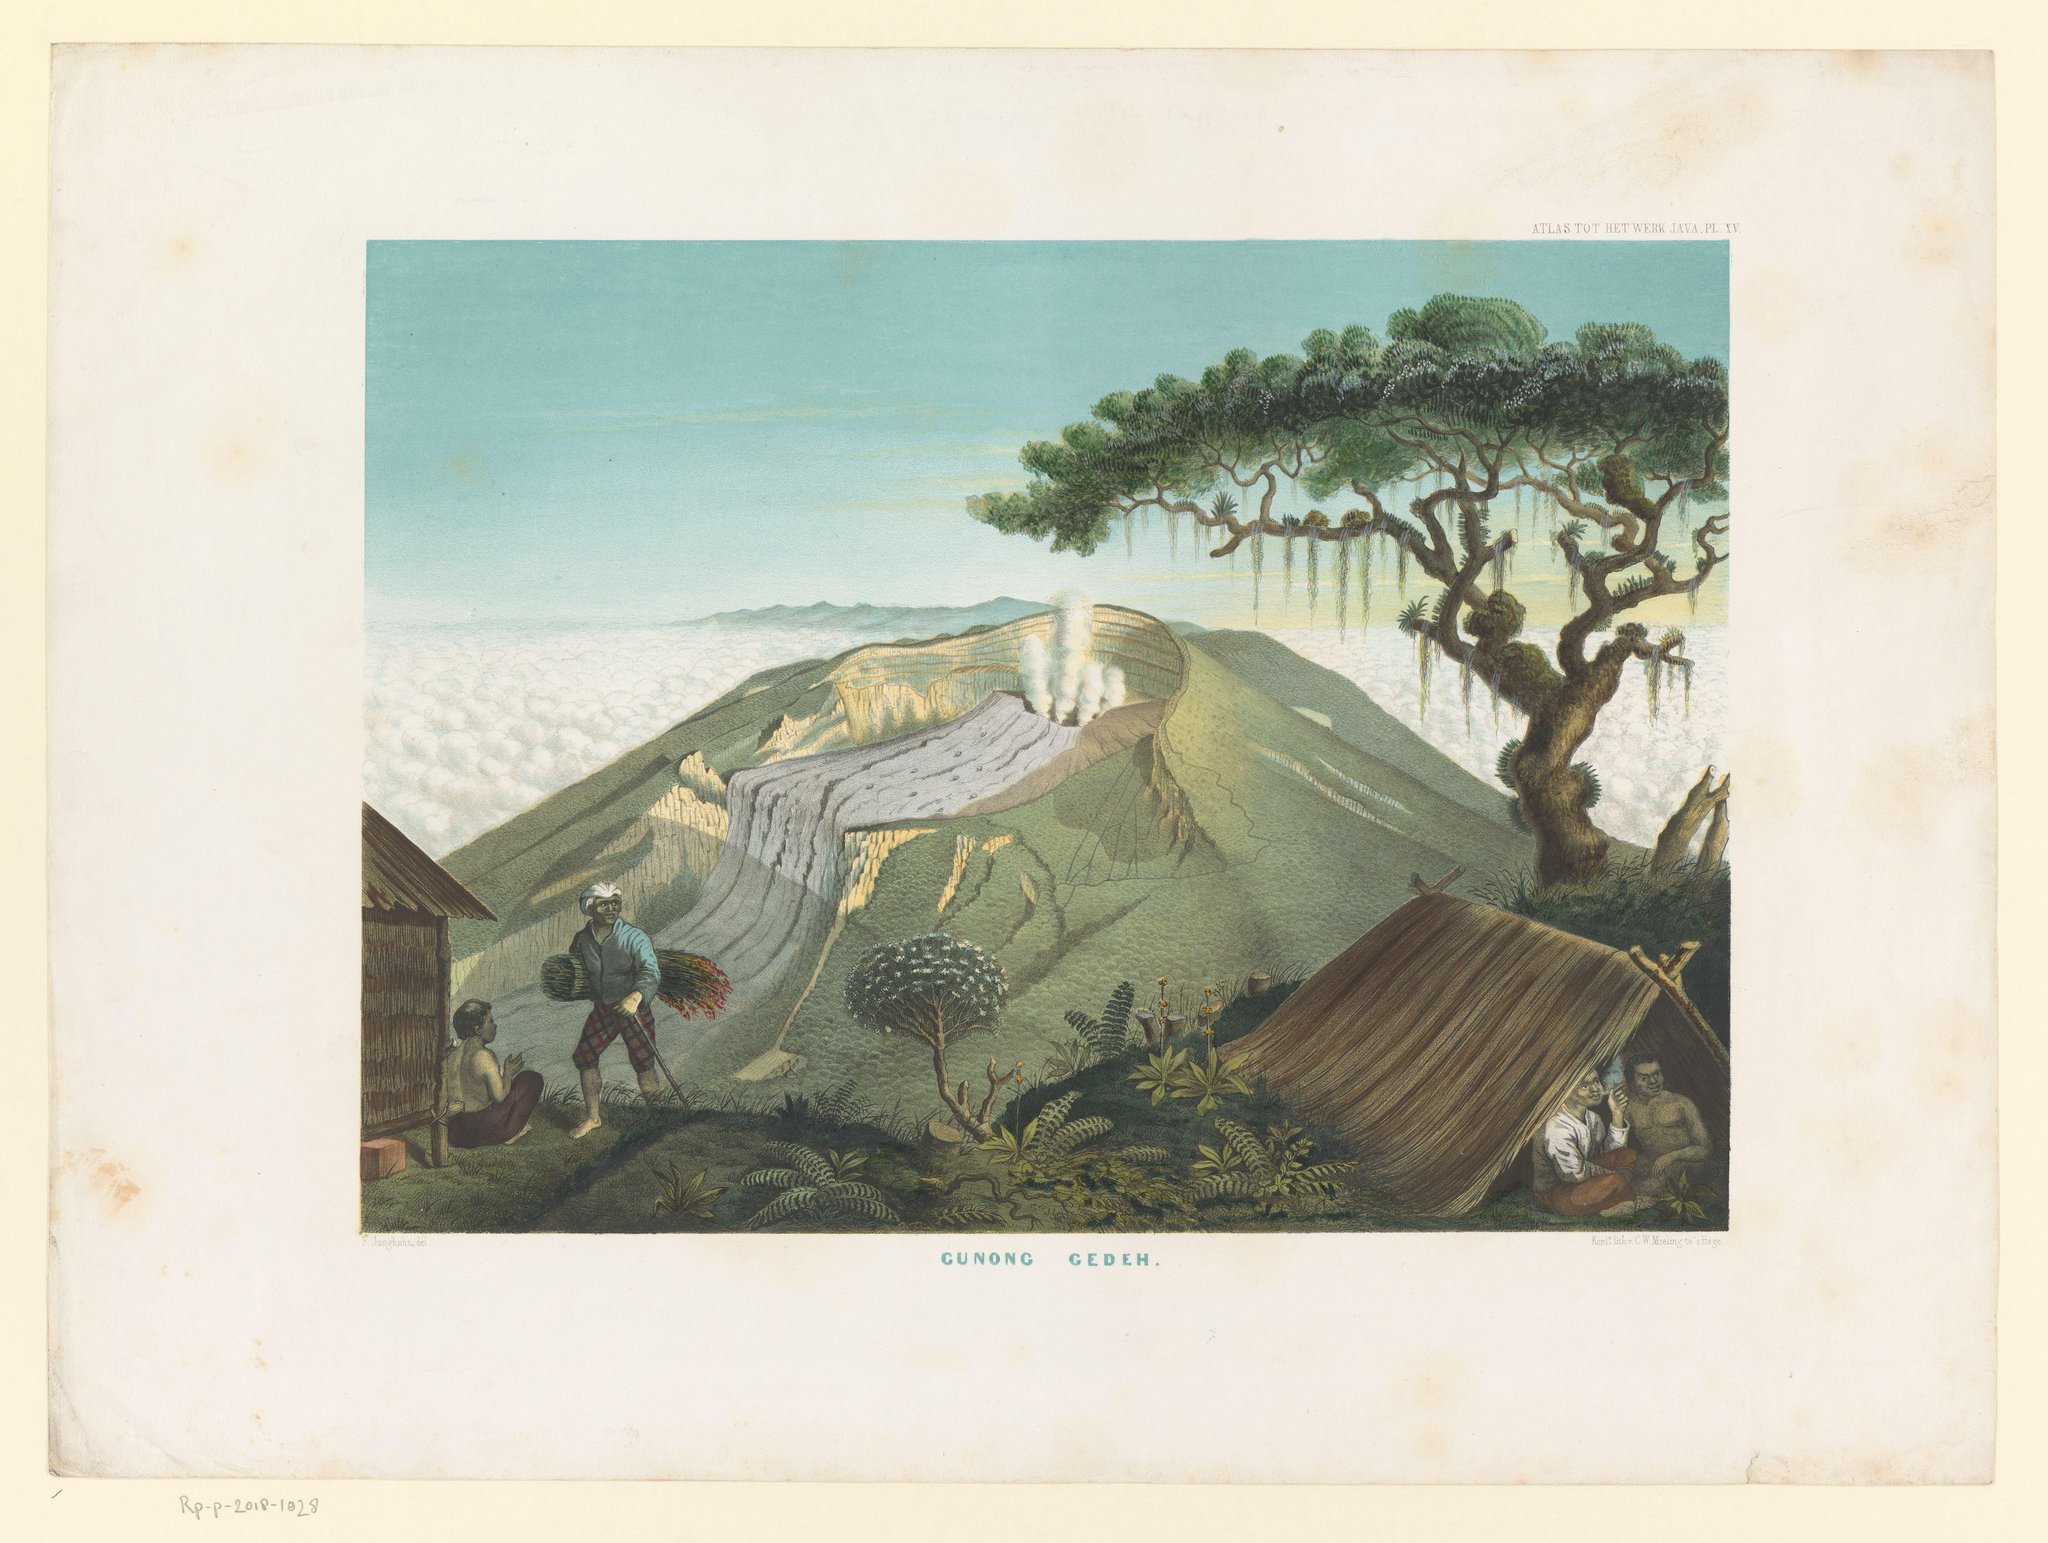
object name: print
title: Gunong Gedeh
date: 1854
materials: paper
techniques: lithograph, hand coloring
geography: the hague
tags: volcano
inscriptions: collector's mark: Lugt 2228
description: Onderdeel van een serie van elf, bedoeld als aanvulling op: Junghuhn, Franz. Java: zijne gedaante, zijn plantentooi en inwendige bouw. 4 dln. Den Haag: Carl Wilheml Mieling, 1853-1854.